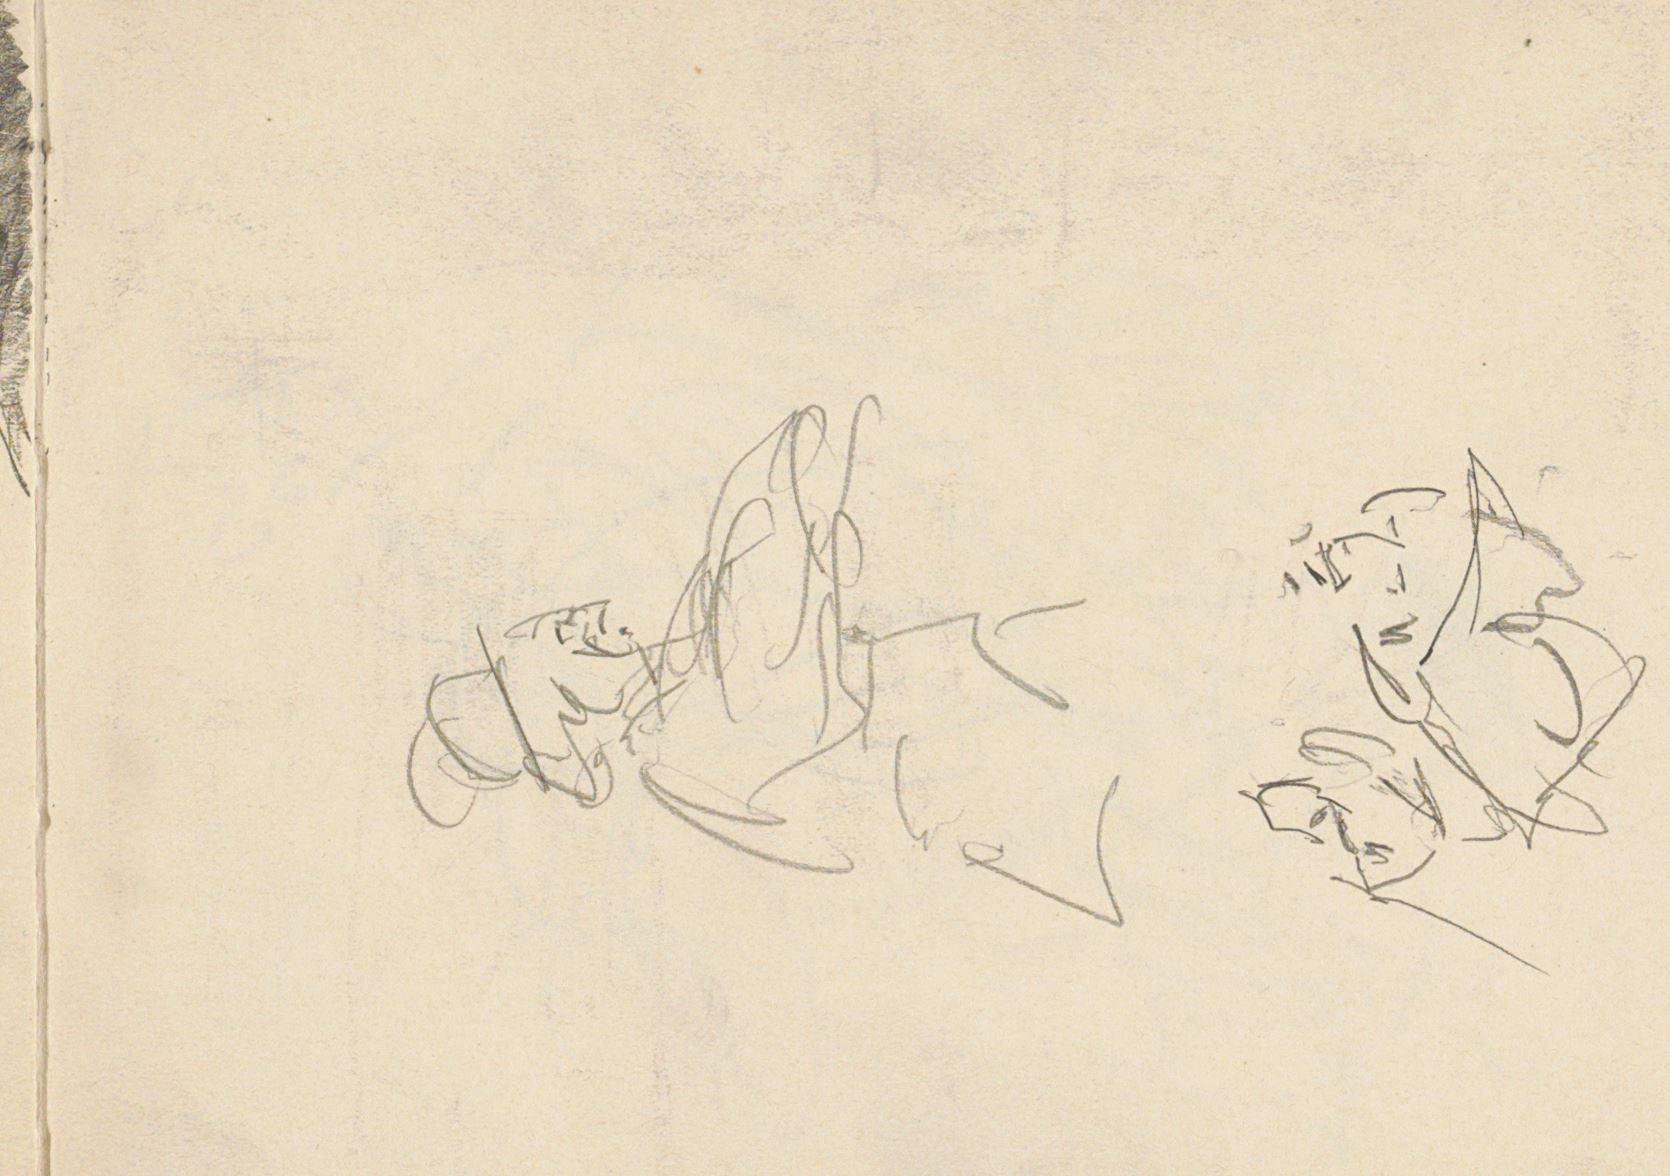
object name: sketchbook leaf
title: Figuurstudies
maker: isaac israels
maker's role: draughtsman, painter, print maker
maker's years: 1865-1934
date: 1930-1934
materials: paper, pencil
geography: the hague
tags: head (human), the (nude) human figure; 'corpo humano' (ripa) (+ sideview, profile)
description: Twee hoofden en een figuur met hoed, in profiel. Pagina 14 uit schetsboek XXXVIII met 45 pagina's.